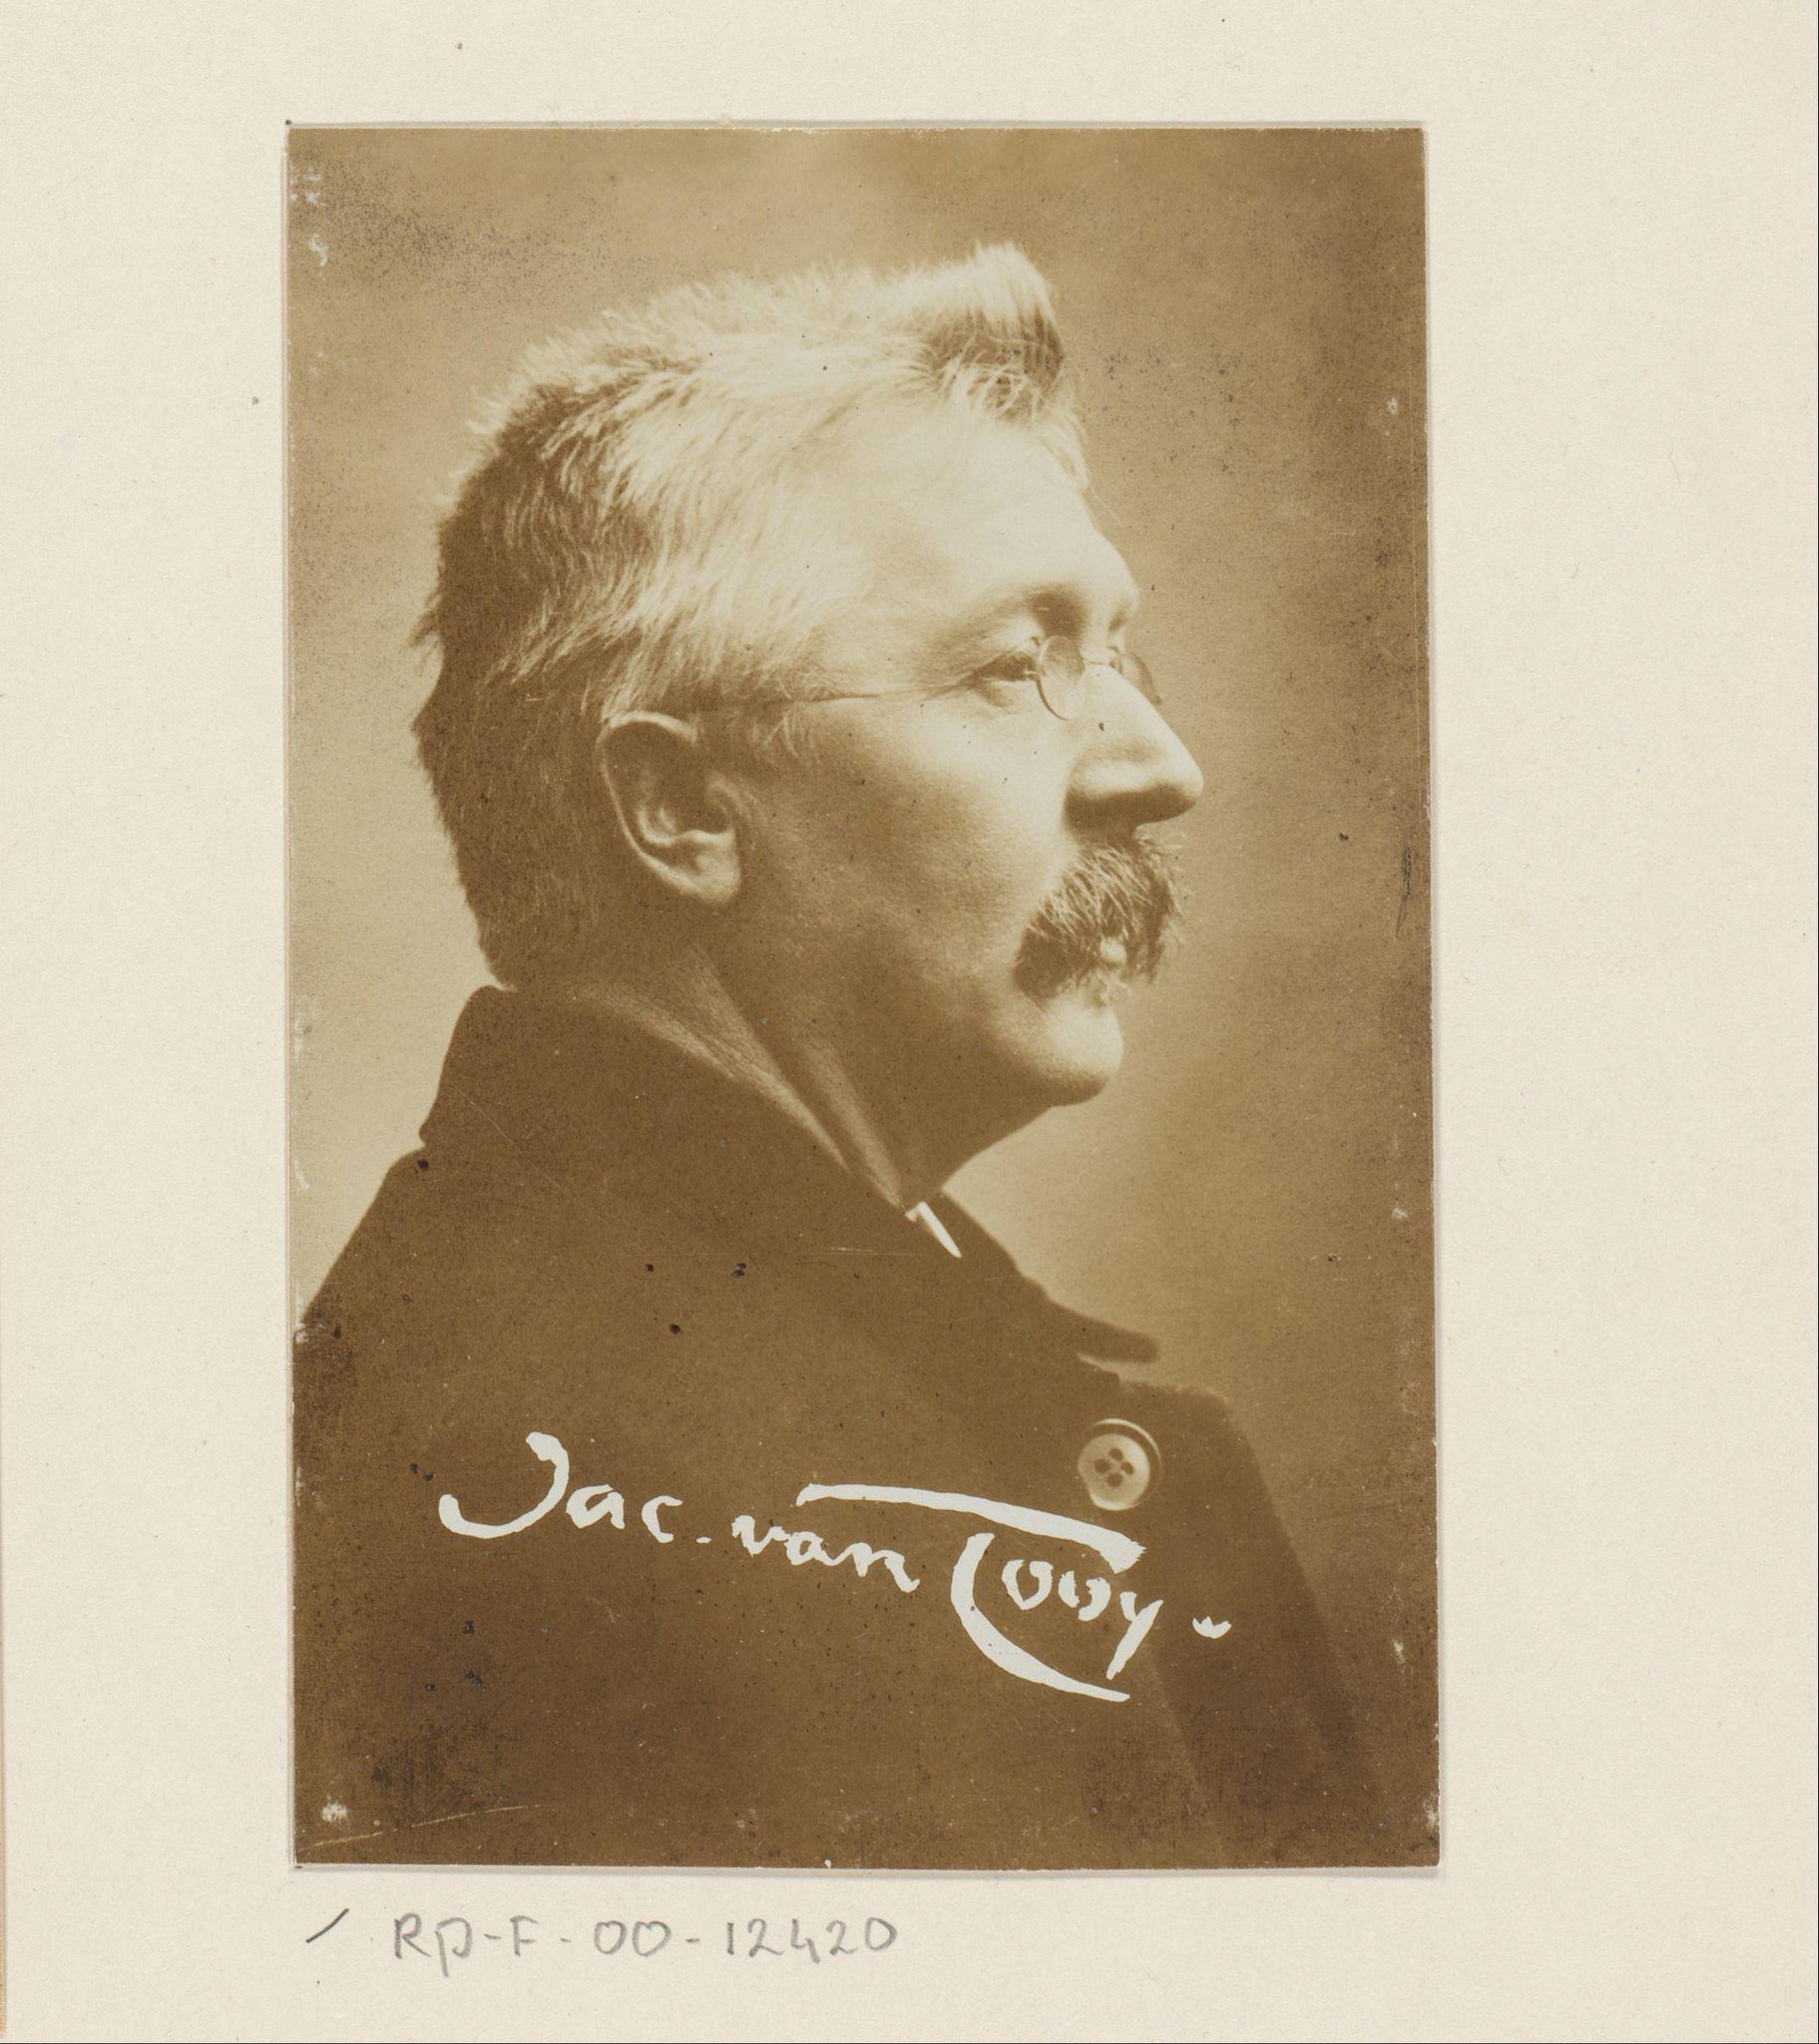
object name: ansichtkaart, prentbriefkaart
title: Portret van Jac van Looy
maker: Anonymous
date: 1910-1920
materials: paper, cardboard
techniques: gelatin silver print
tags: haarlem, painter, print maker, draughtsman, jac van looij, portrait, self-portrait of artist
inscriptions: inscription: ‘Jac. van Looy.’